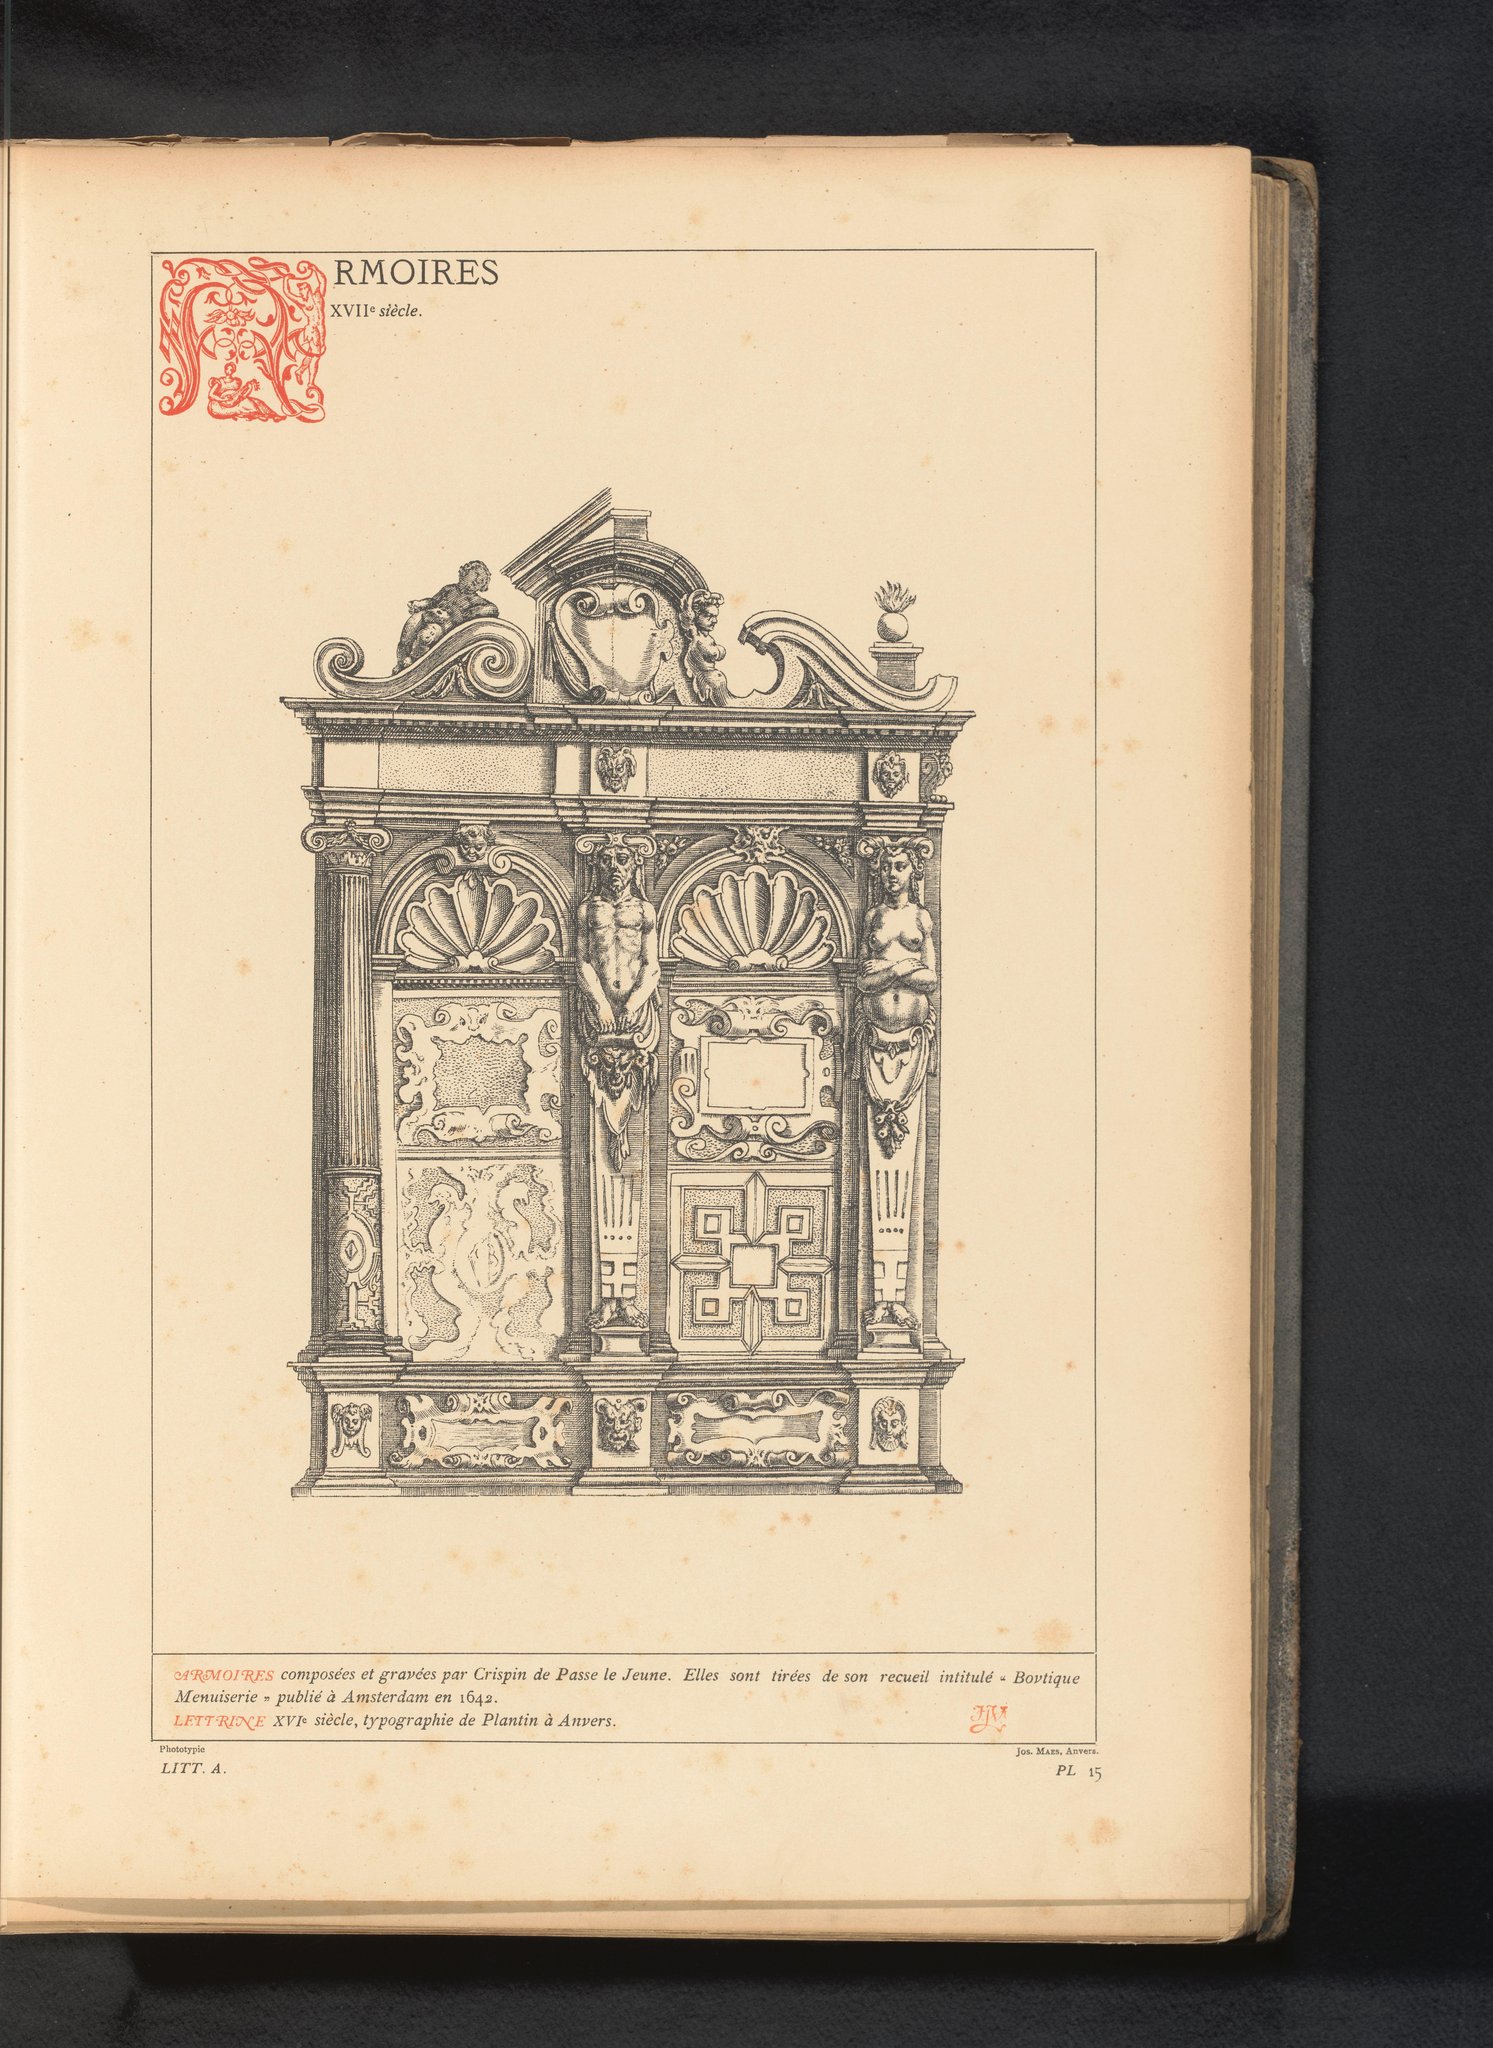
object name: reproduction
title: Armoires, XVIIe Siècle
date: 1875-1880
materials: paper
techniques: photolithography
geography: antwerp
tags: coat of arms (as symbol of the state, etc.)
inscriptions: inscription: ‘Armoires composées et (...)’, inscription: ‘LITT: A. - PL. 15’, monogram: ‘JJvY’